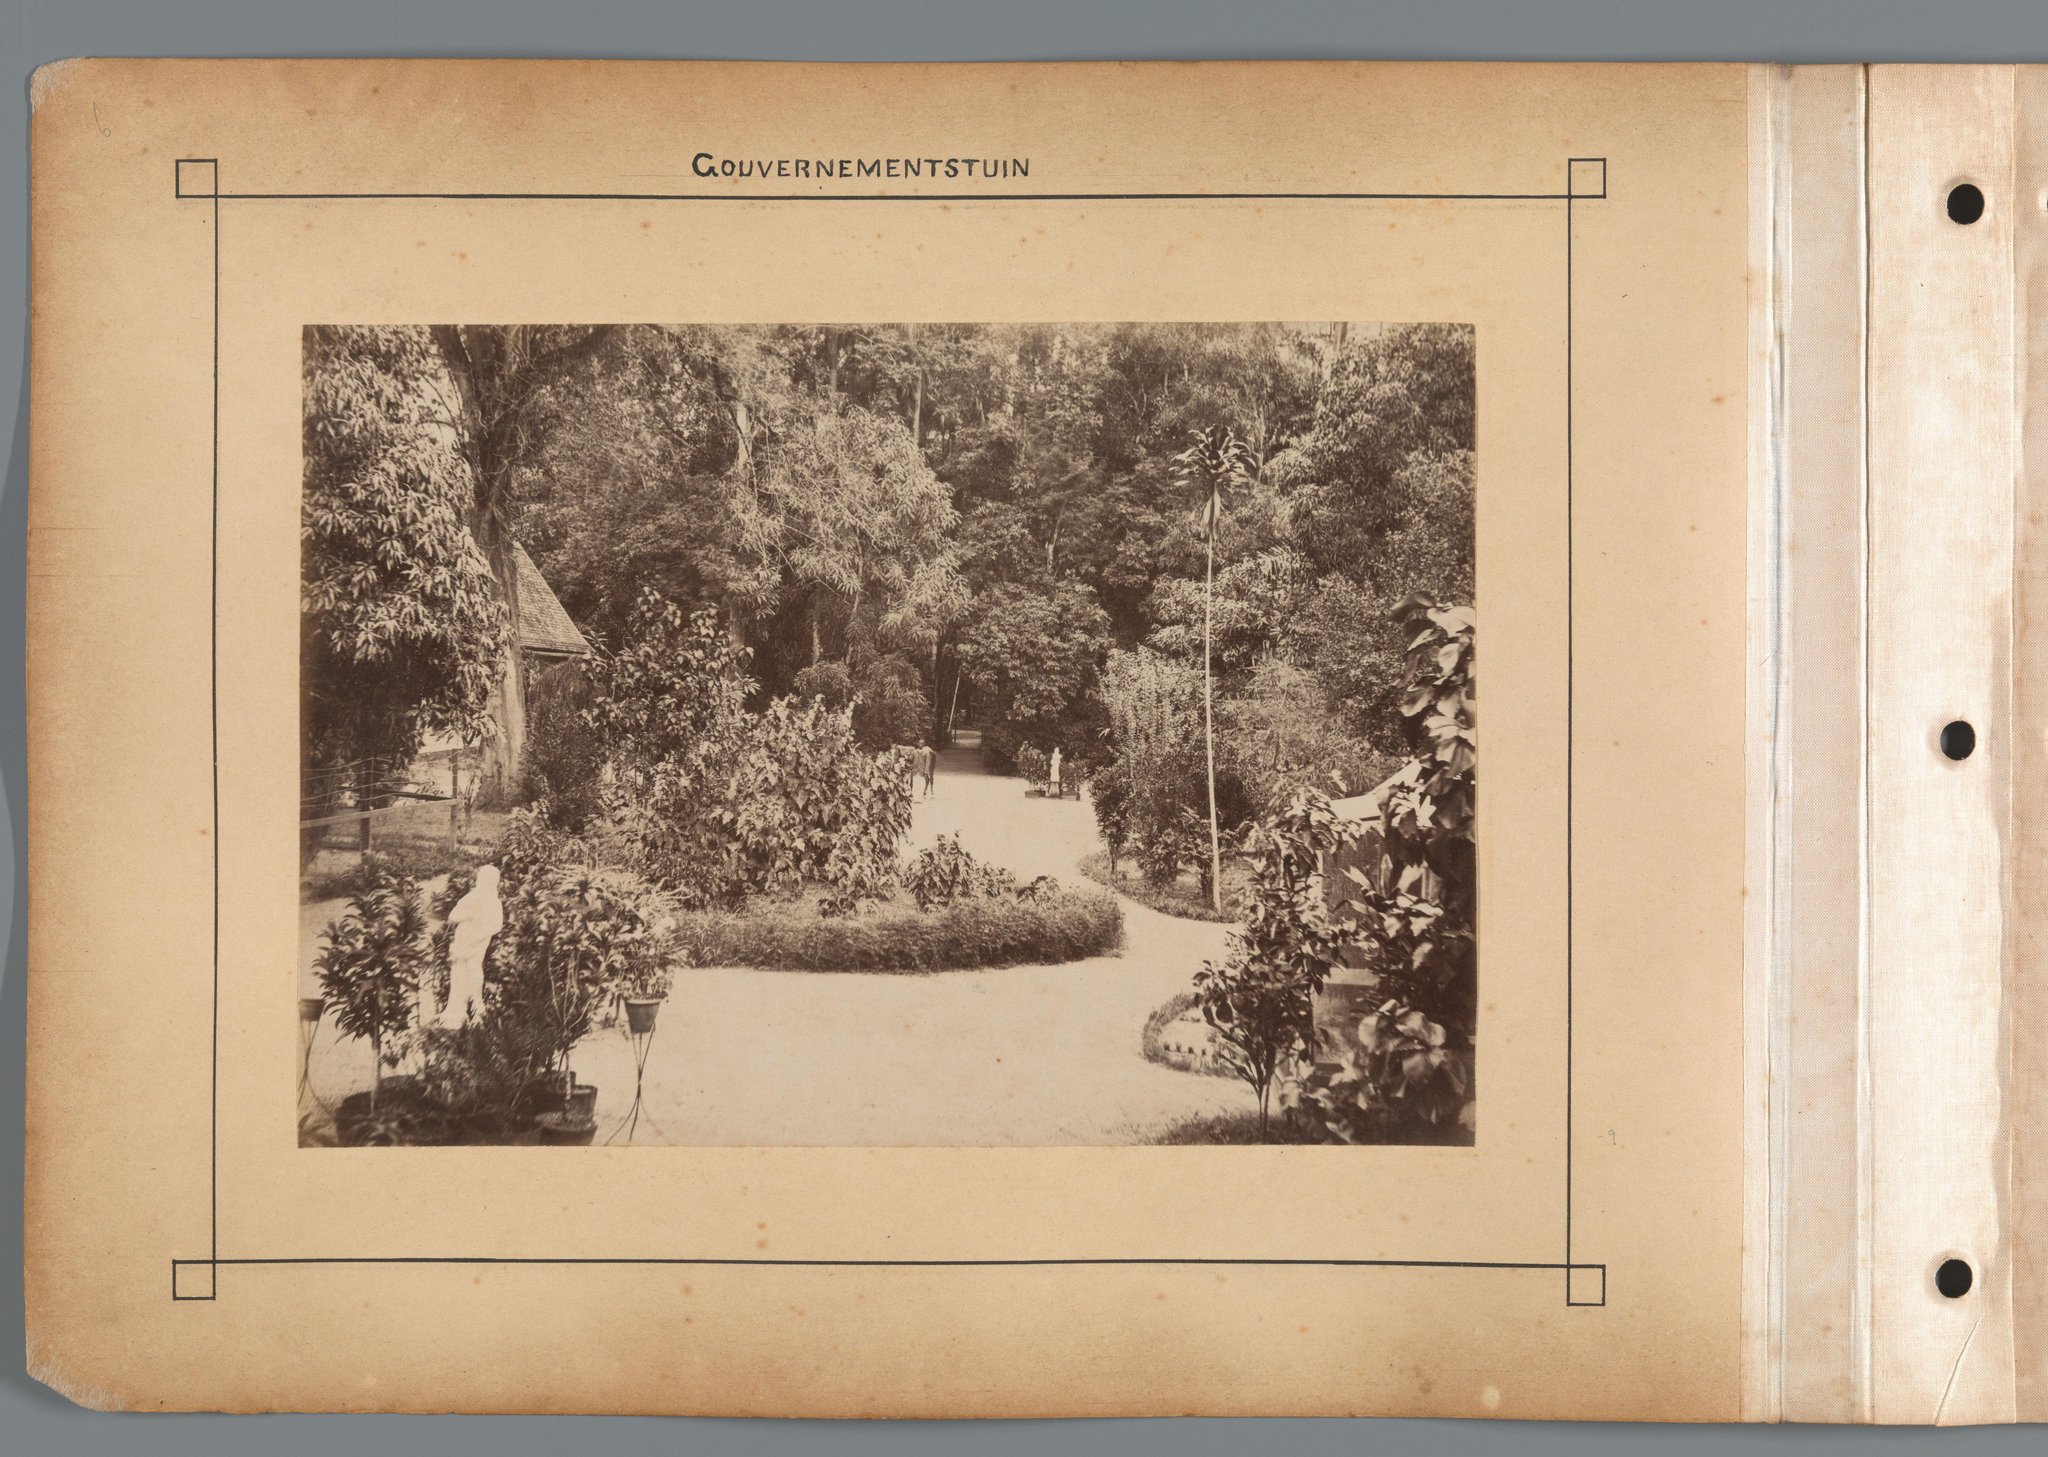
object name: photograph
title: Gouvernementstuin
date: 1898-1902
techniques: albumen print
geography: suriname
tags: suriname